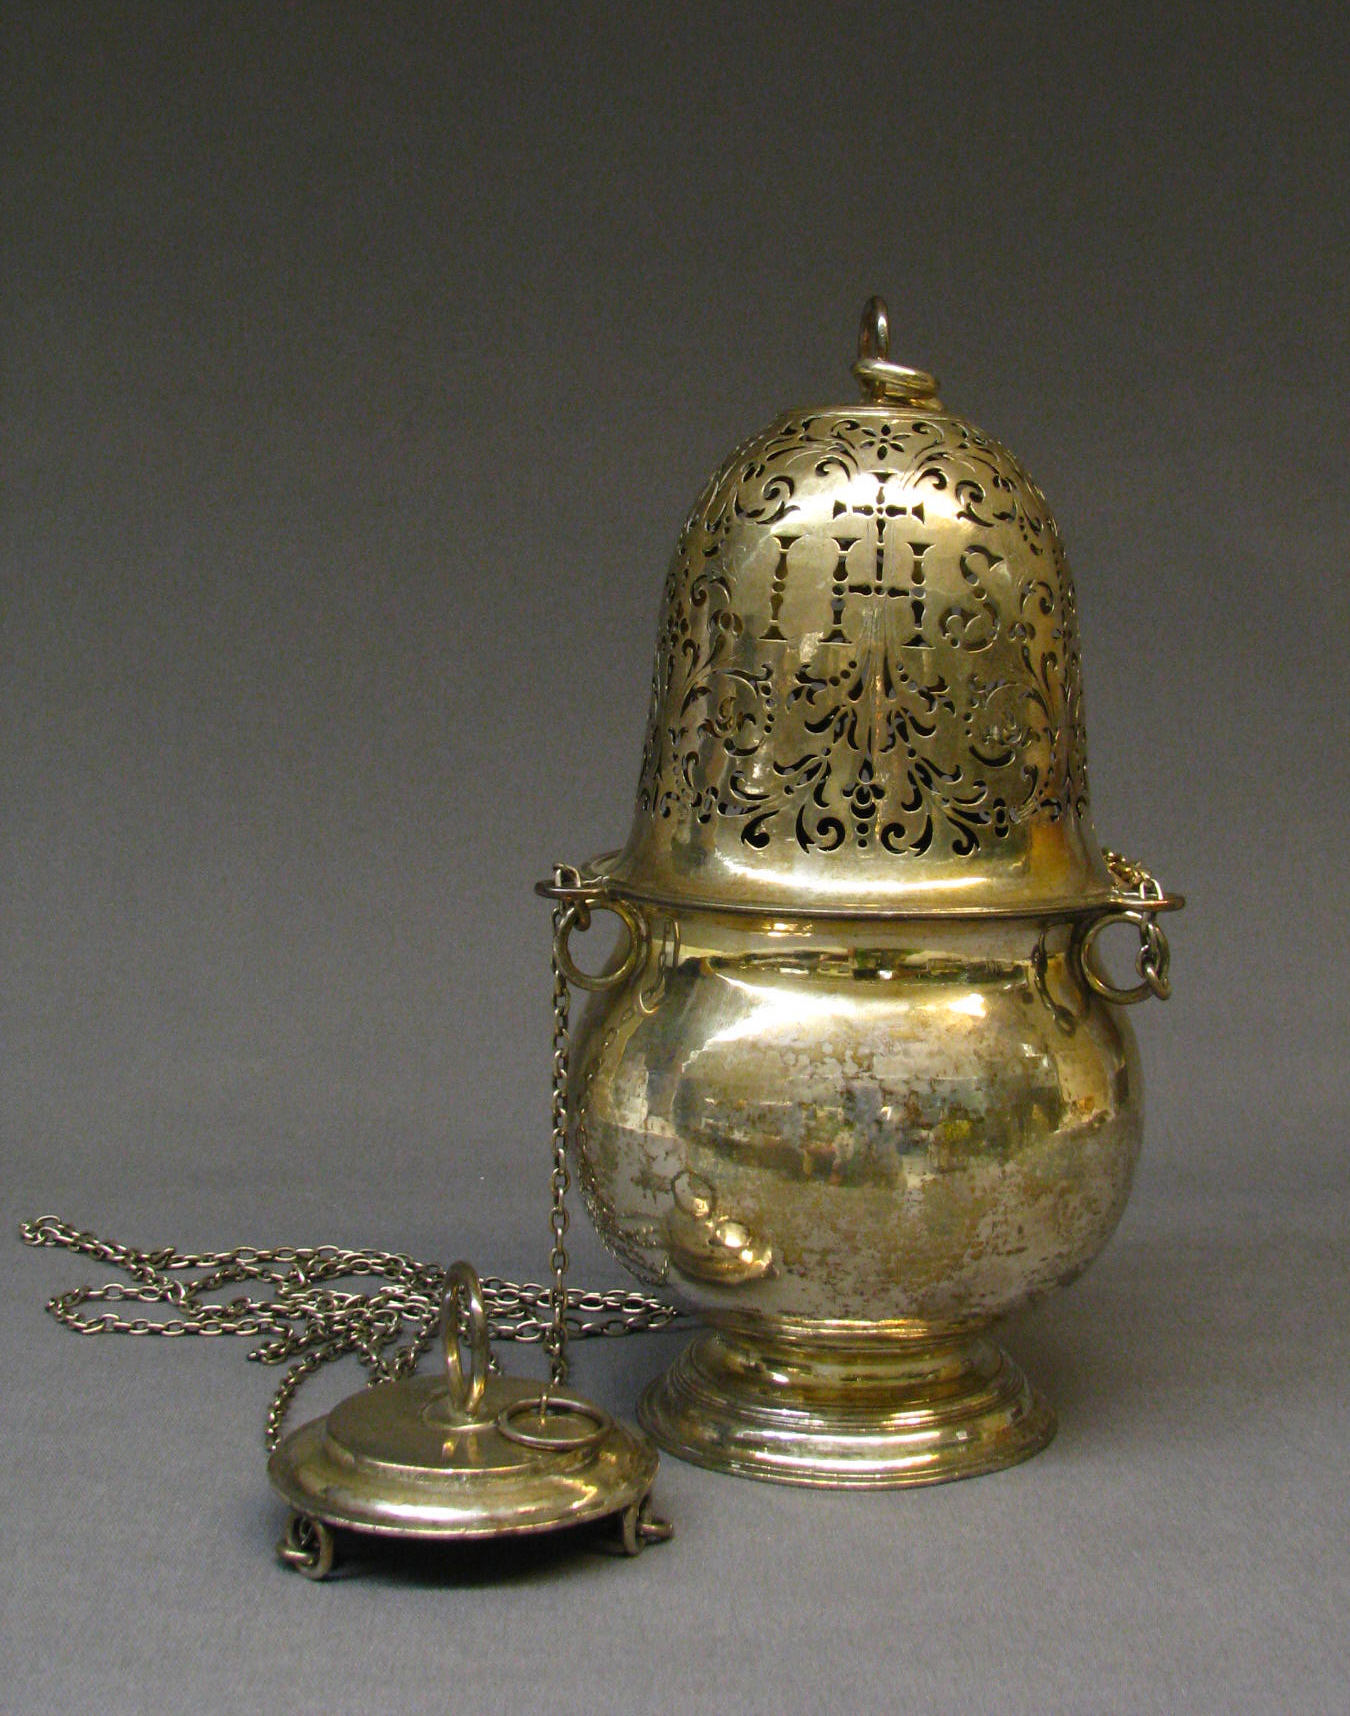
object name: censer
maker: benjamin pyne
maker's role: maker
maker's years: 1693-1727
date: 1708-1709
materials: silver